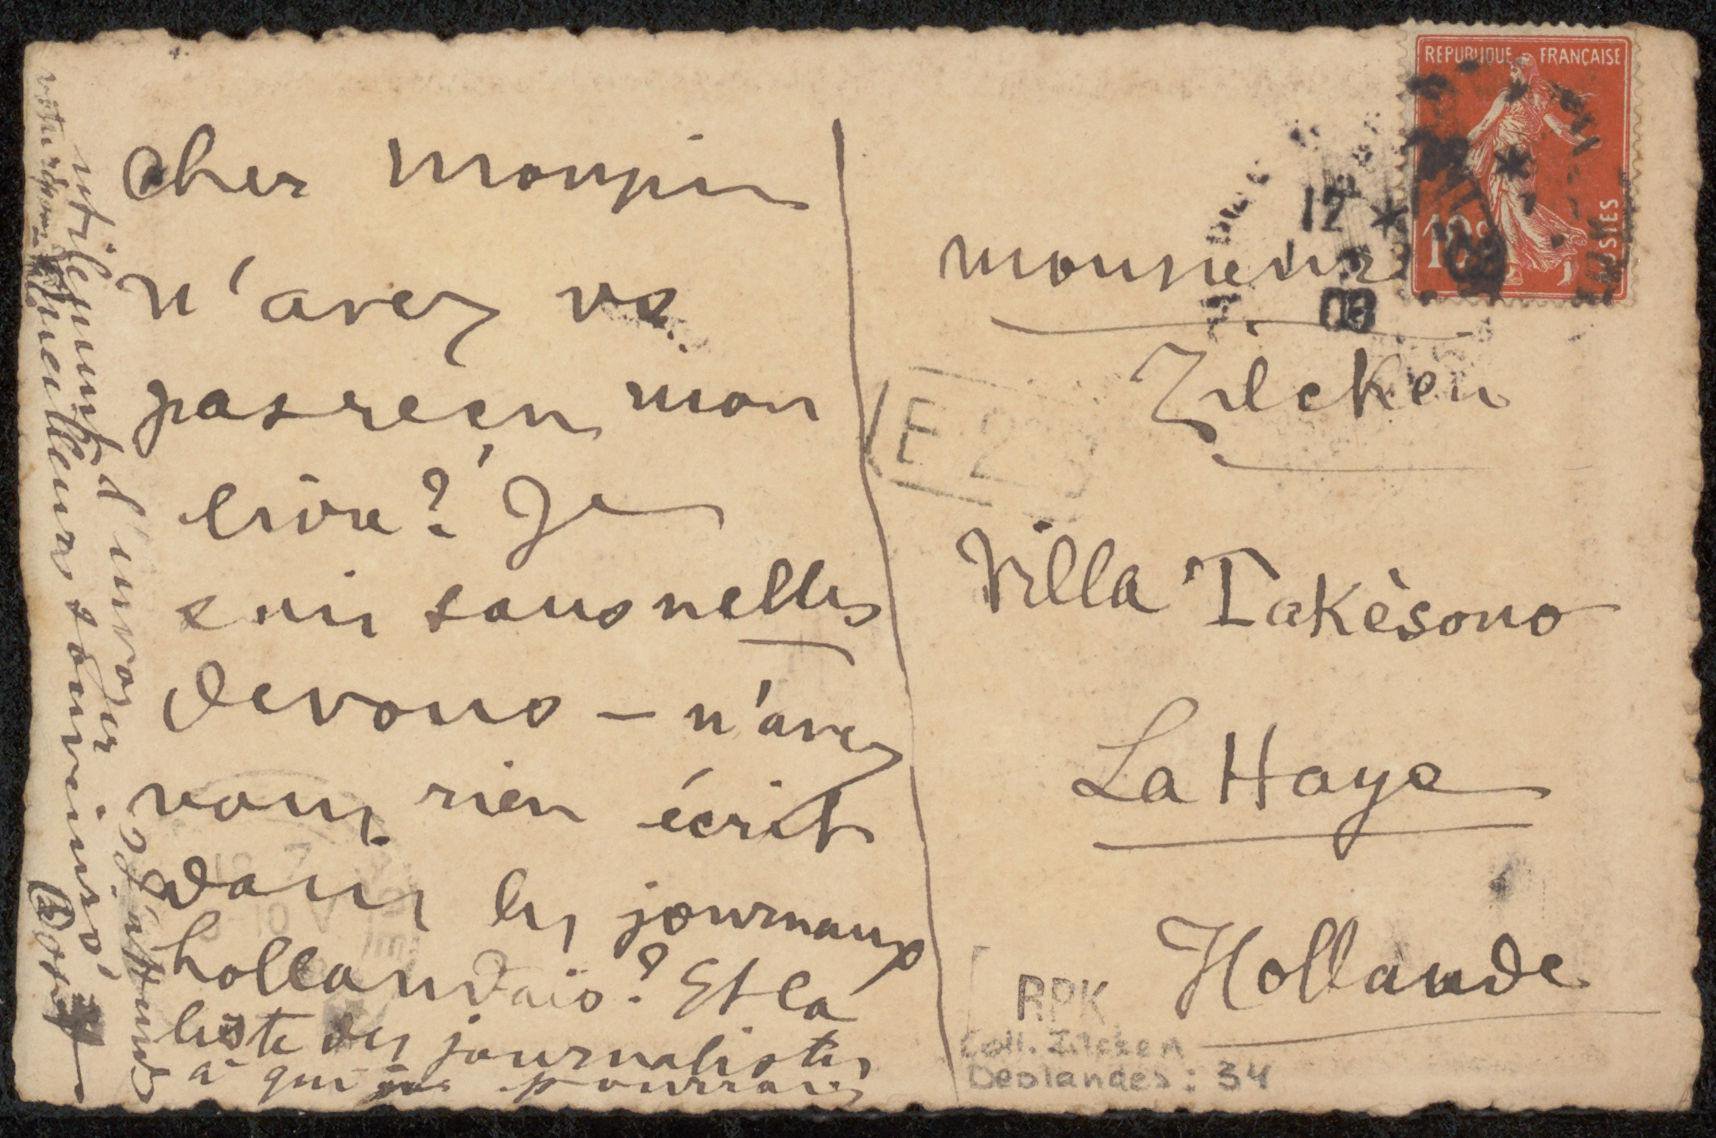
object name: ansichtkaart, prentbriefkaart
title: Prentbriefkaart aan Philip Zilcken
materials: cardboard, ink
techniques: etching, pen, writing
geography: paris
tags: painter, draughtsman, philip zilcken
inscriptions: collector's mark: ‘RPK’